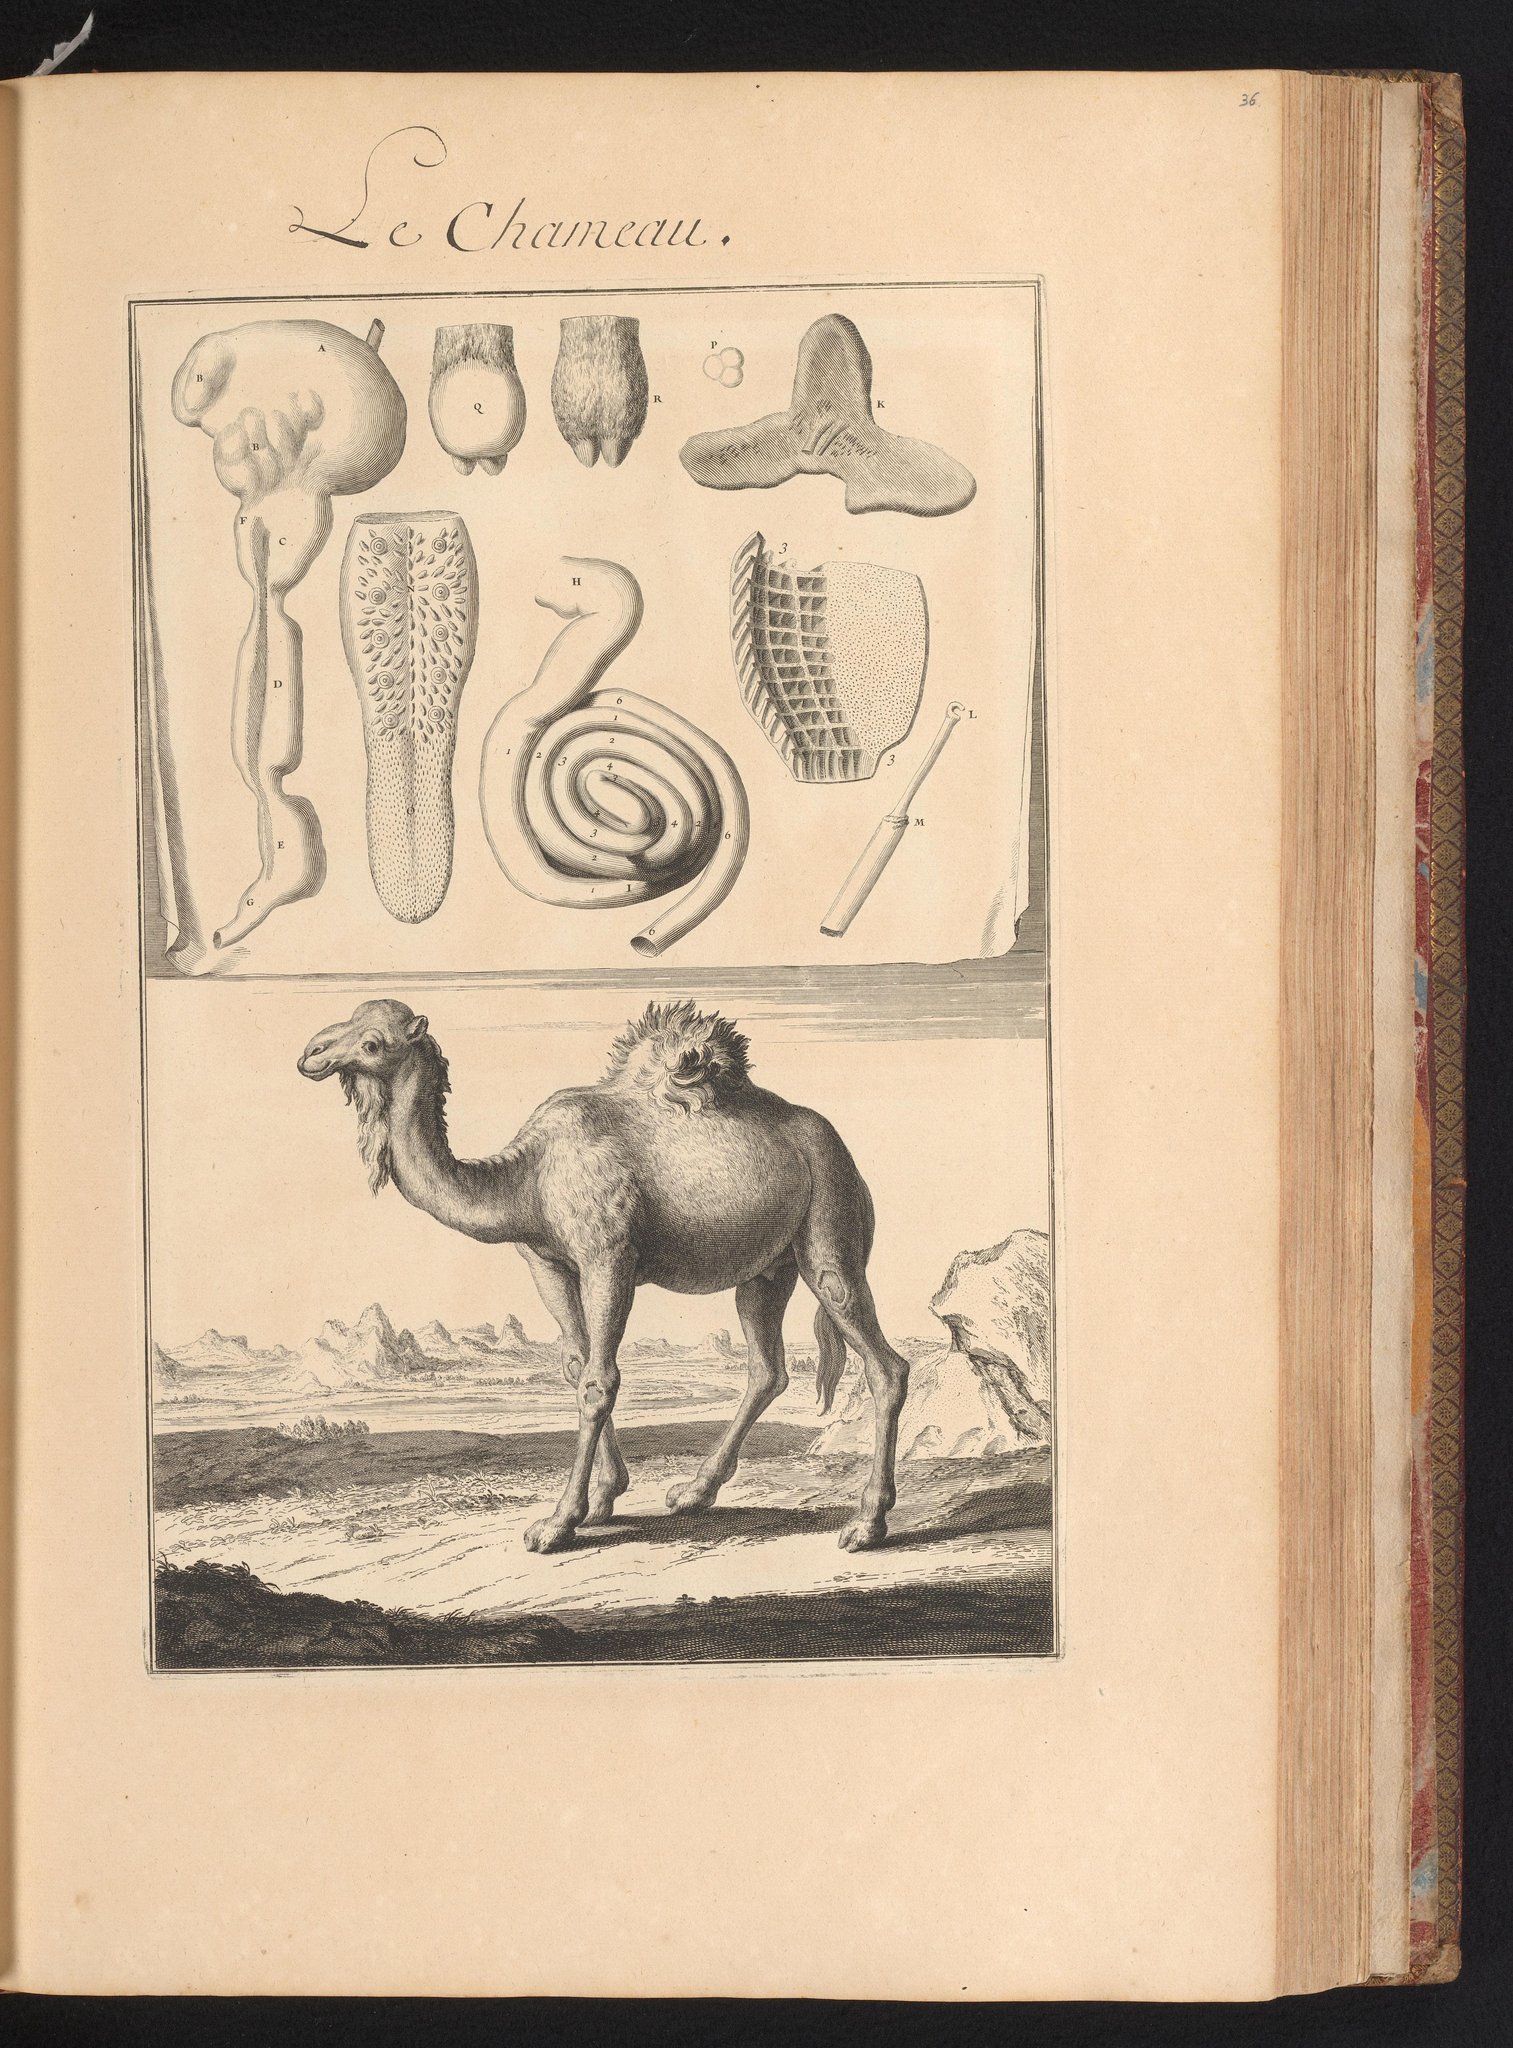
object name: book illustration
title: Kameel in een landschap met bovenaan op een blad de organen van het dier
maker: louis de châtillon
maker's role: print maker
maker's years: 1639-1734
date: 1649-1734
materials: ink, paper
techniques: engraving, etching, pen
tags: hoofed animals: camel, dissection, animals (+ anatomy of animals)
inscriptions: inscription: ‘Le Chameau.’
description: Prent bedoeld voor een editie van Claude Perraults 'Mémoires pour servir à l'histoire naturelle des animaux'.